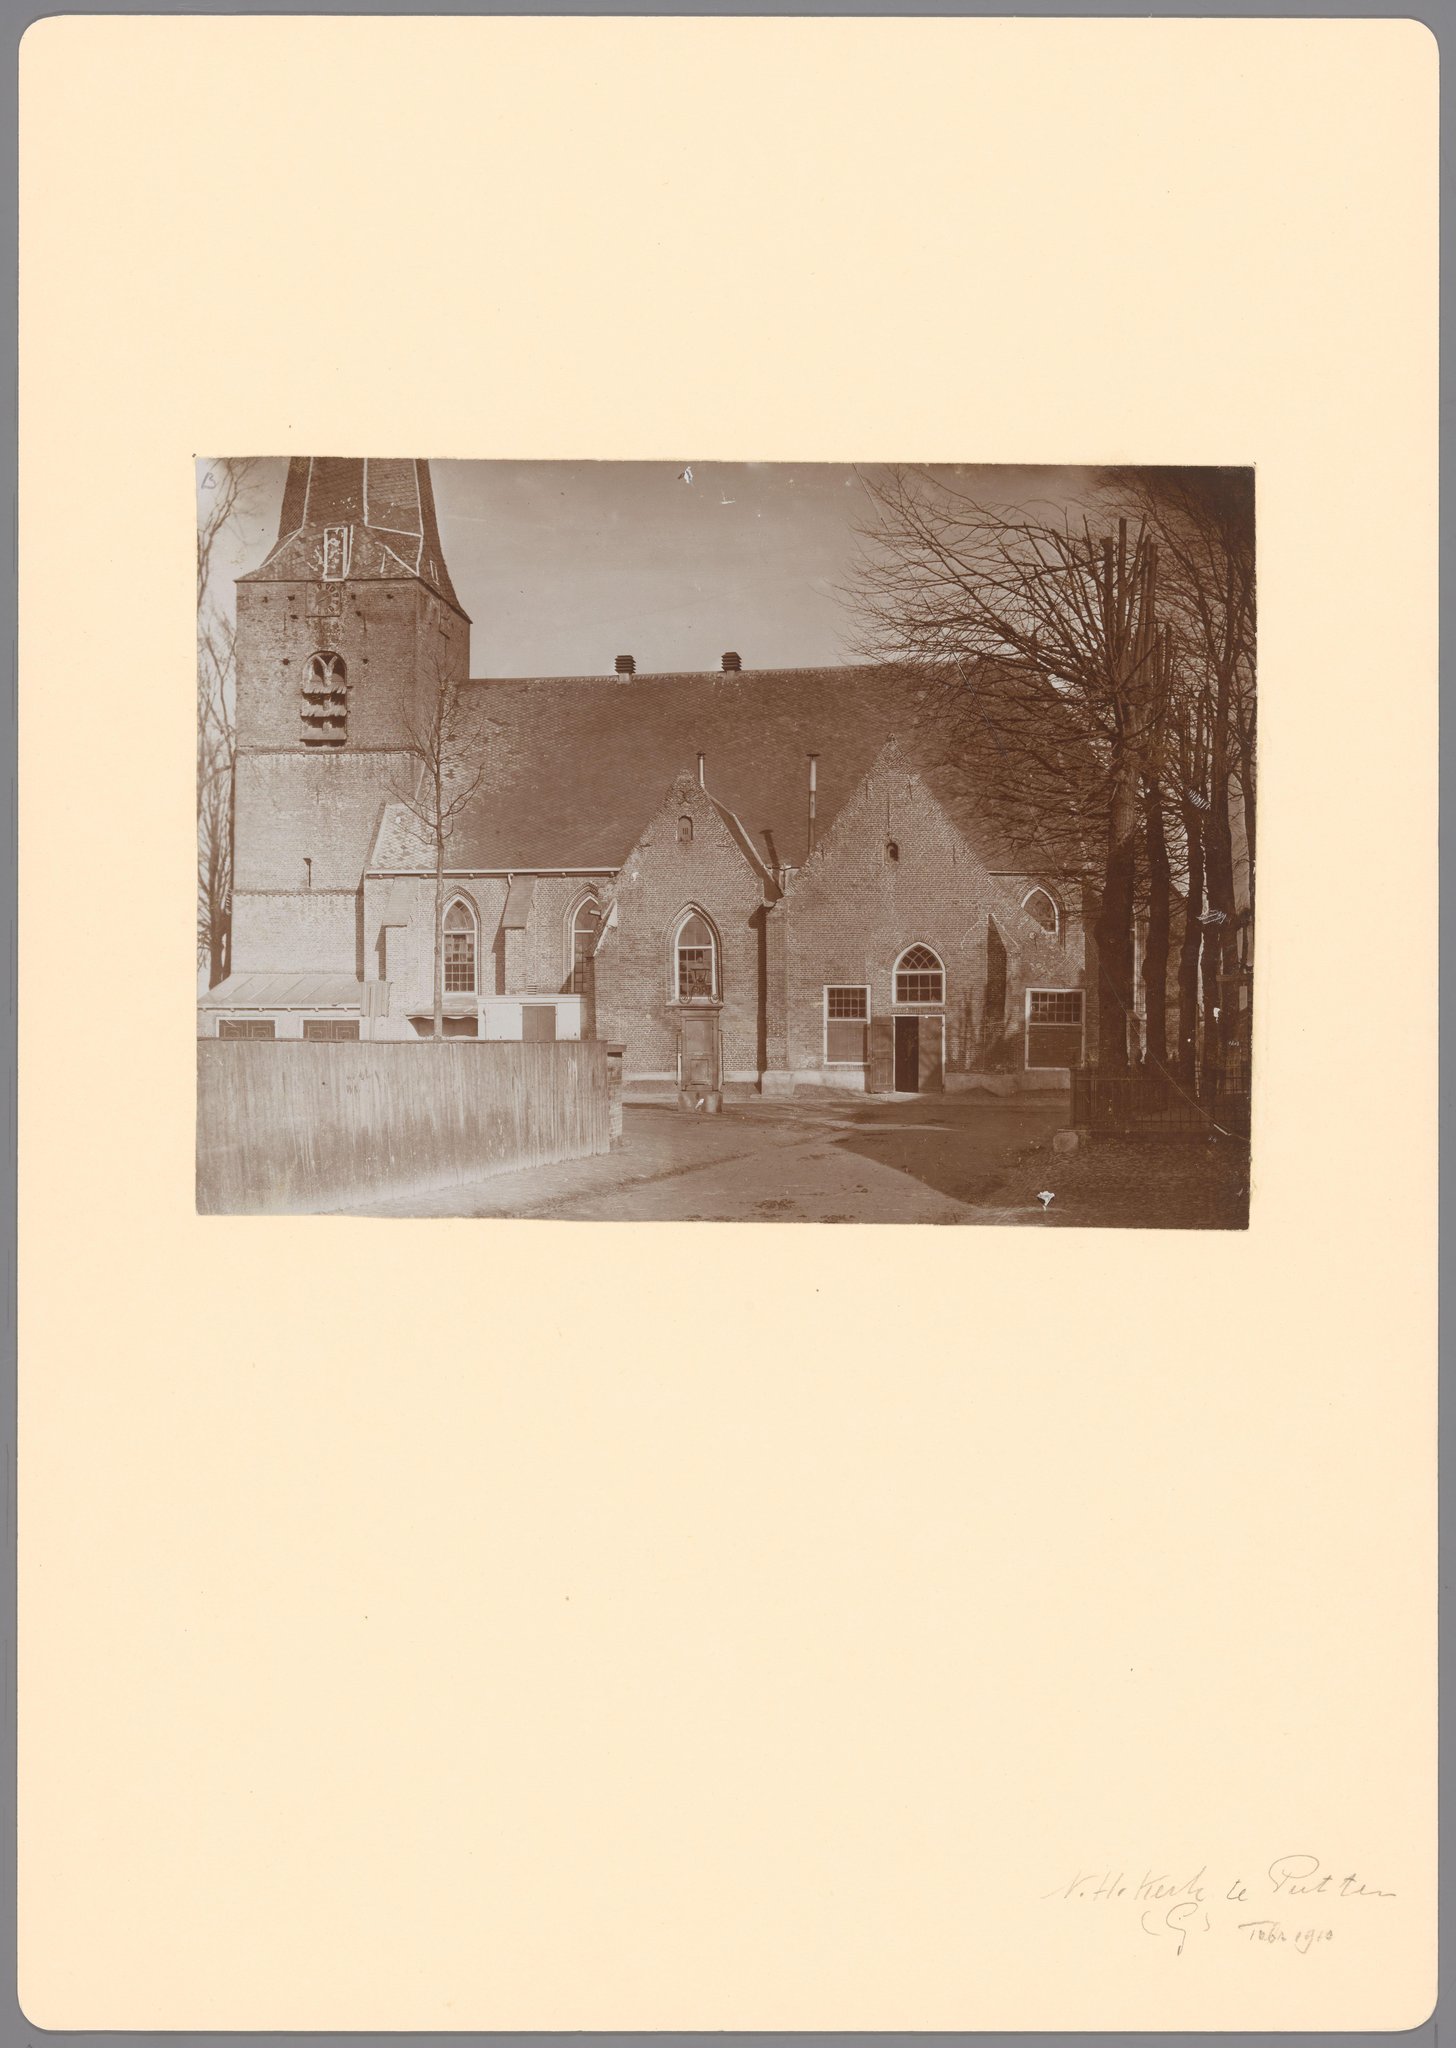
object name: photograph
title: Gezicht op de Hervormde Kerk te Putten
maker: anoniem (monumentenzorg)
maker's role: fotograaf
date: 1910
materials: cardboard, photographic support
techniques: collodion silver print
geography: putten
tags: church (exterior)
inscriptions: annotation: ‘B/ N.H. Kerk te Putten (G.)/ febr 1910’